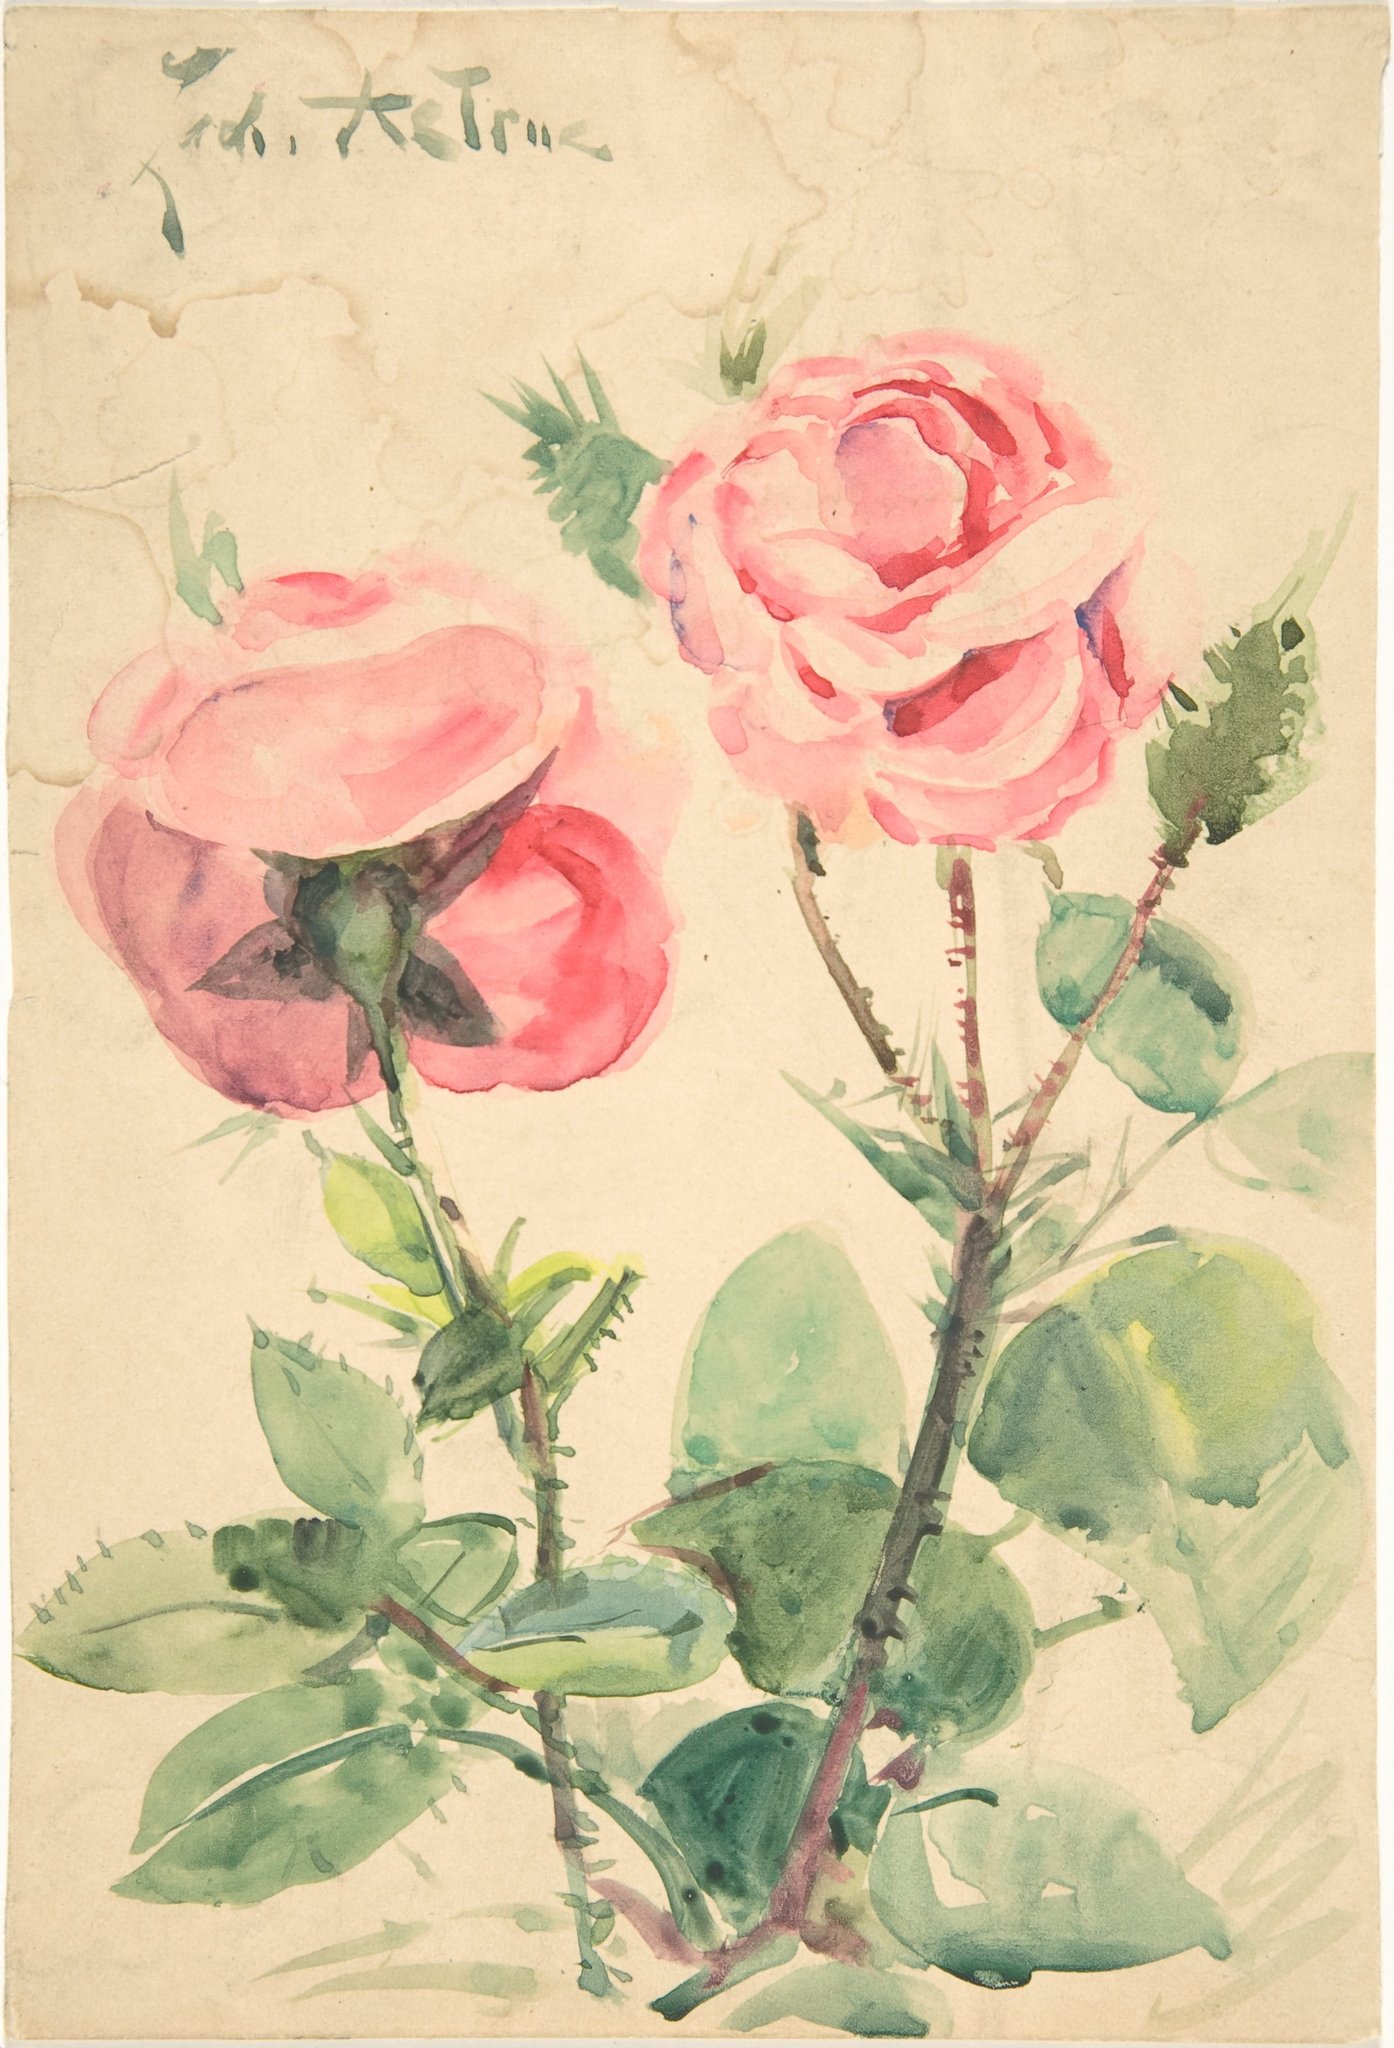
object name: drawing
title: Two Roses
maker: zacharie astruc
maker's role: artist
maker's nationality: french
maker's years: 1833-1907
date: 1884-1904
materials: watercolor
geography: france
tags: roses,leaves